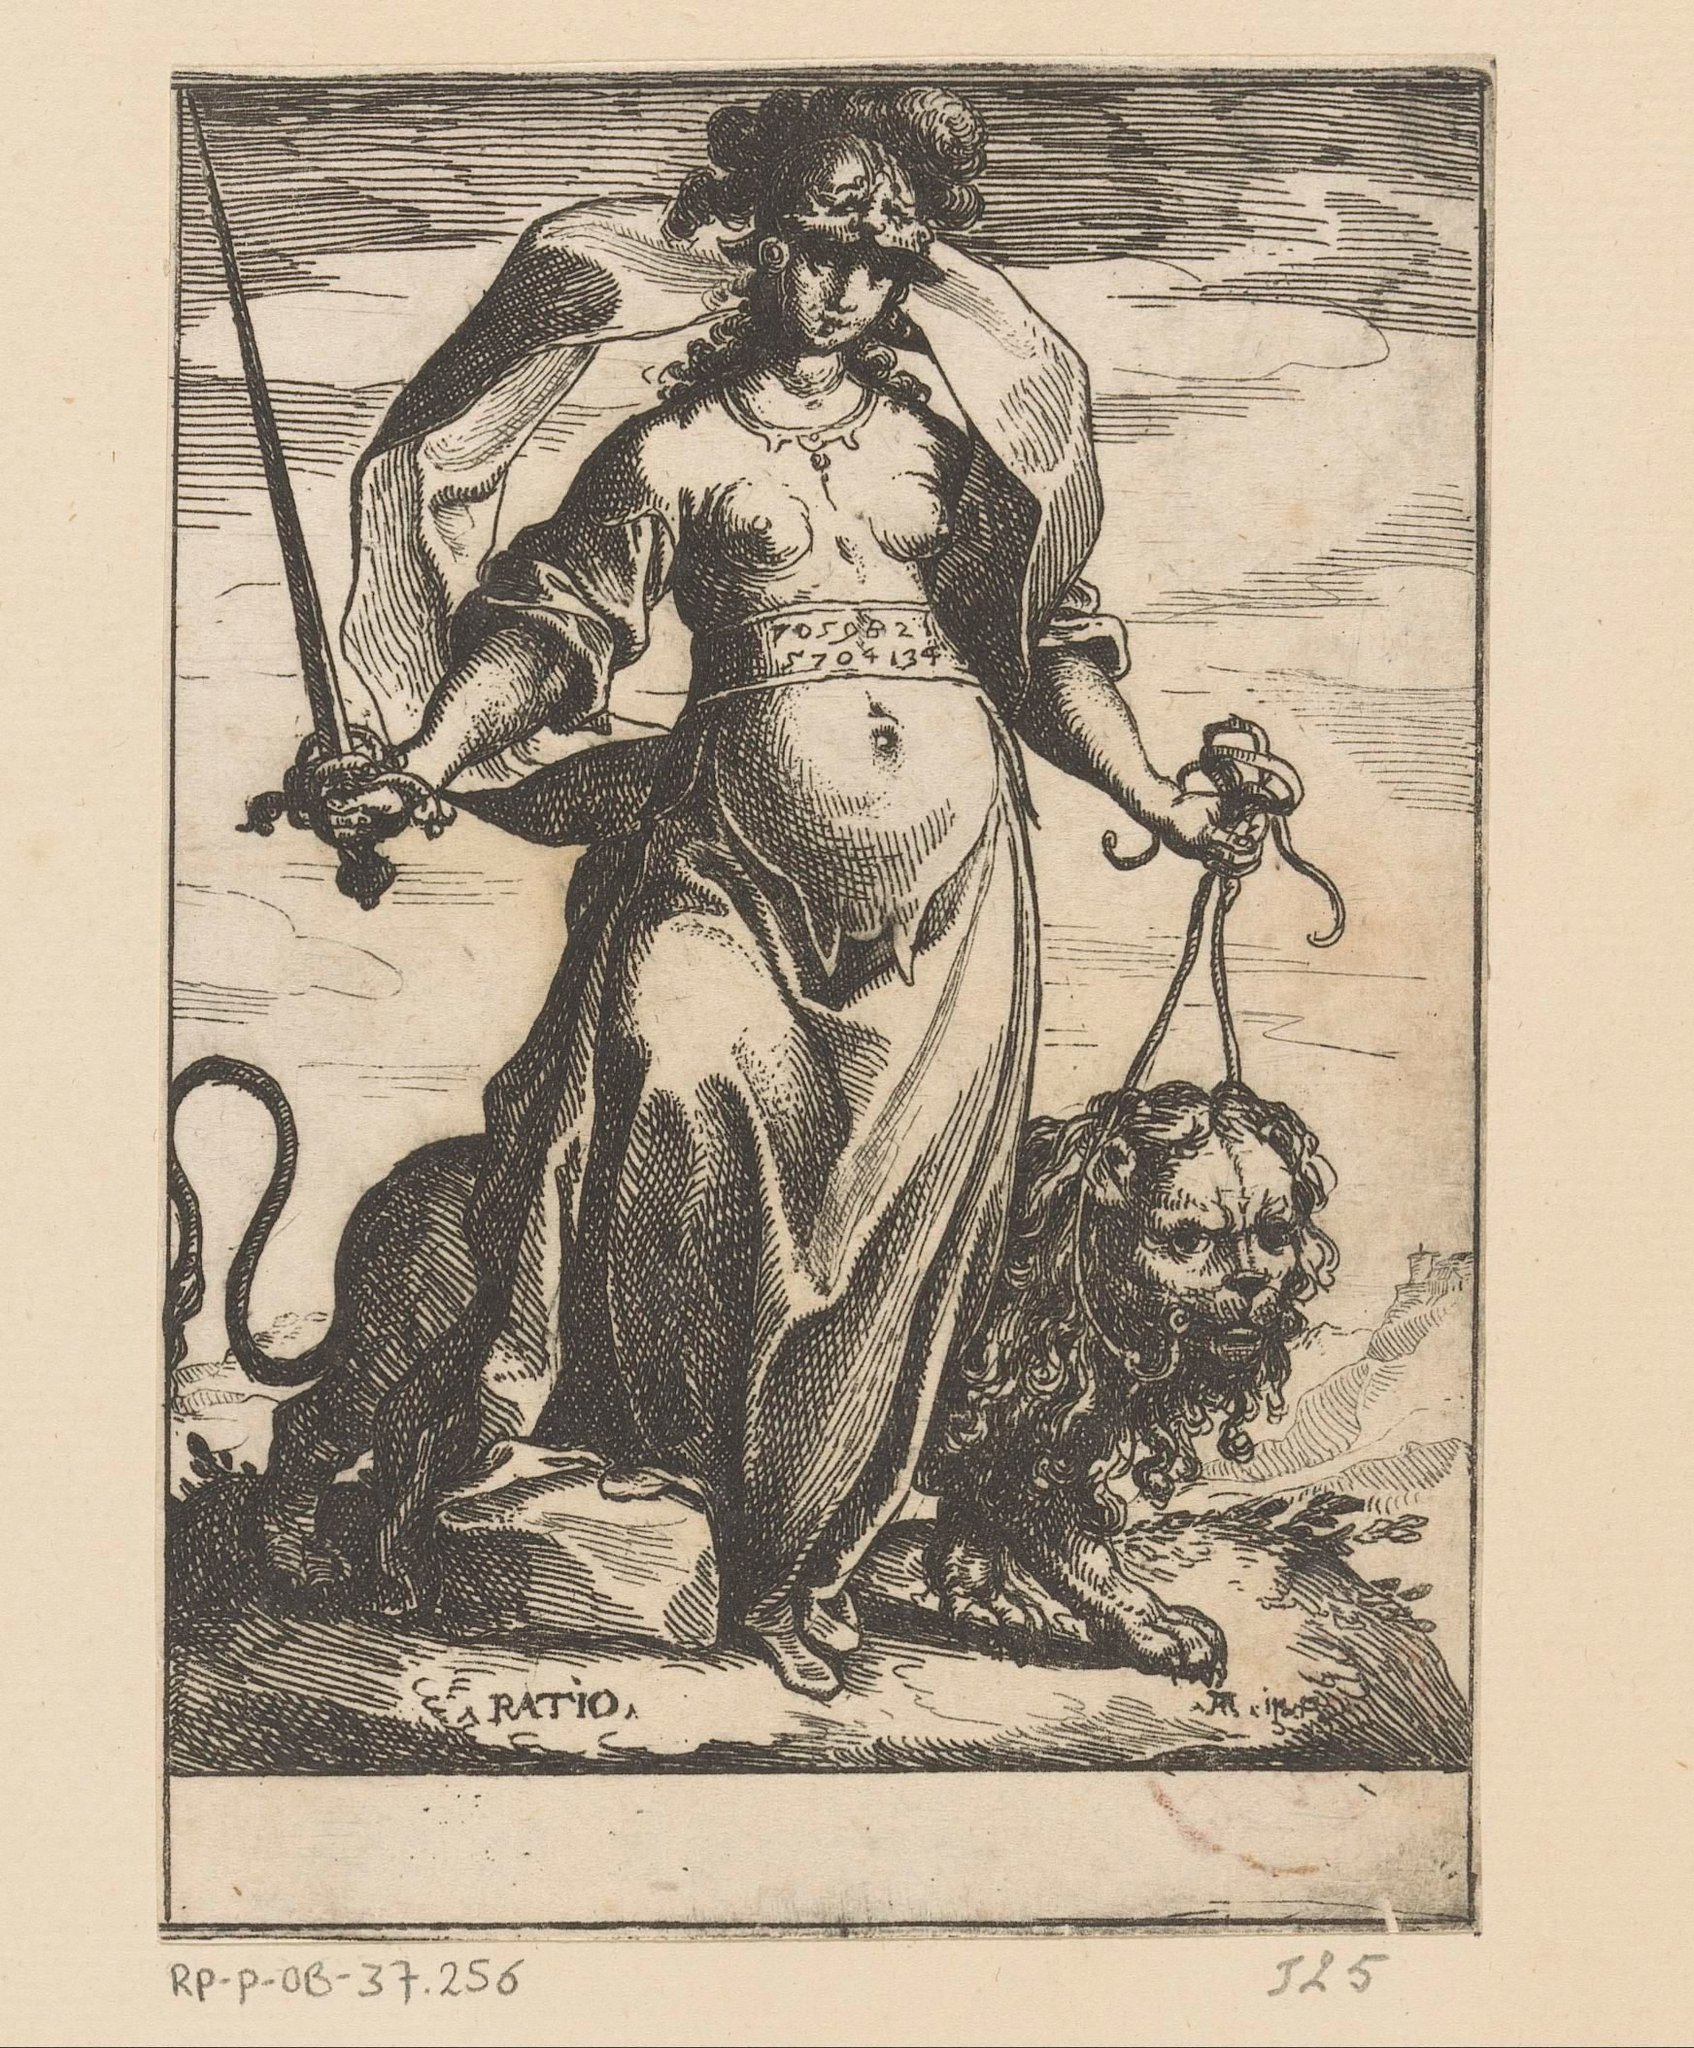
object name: print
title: Attributi dell'Anima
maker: raffaello schiaminossi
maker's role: painter, print maker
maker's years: 1572-1622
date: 1605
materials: paper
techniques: etching, intaglio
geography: italy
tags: rationality, reasoning; 'ratiocinatione o discorso' (ripa), beasts of prey, predatory animals: lion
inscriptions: collector's mark: Lugt 240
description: Deze prent maakt deel uit van de serie 'Attributi dell'Anima', bestaande uit twaalf personificaties gedrukt van zes platen.